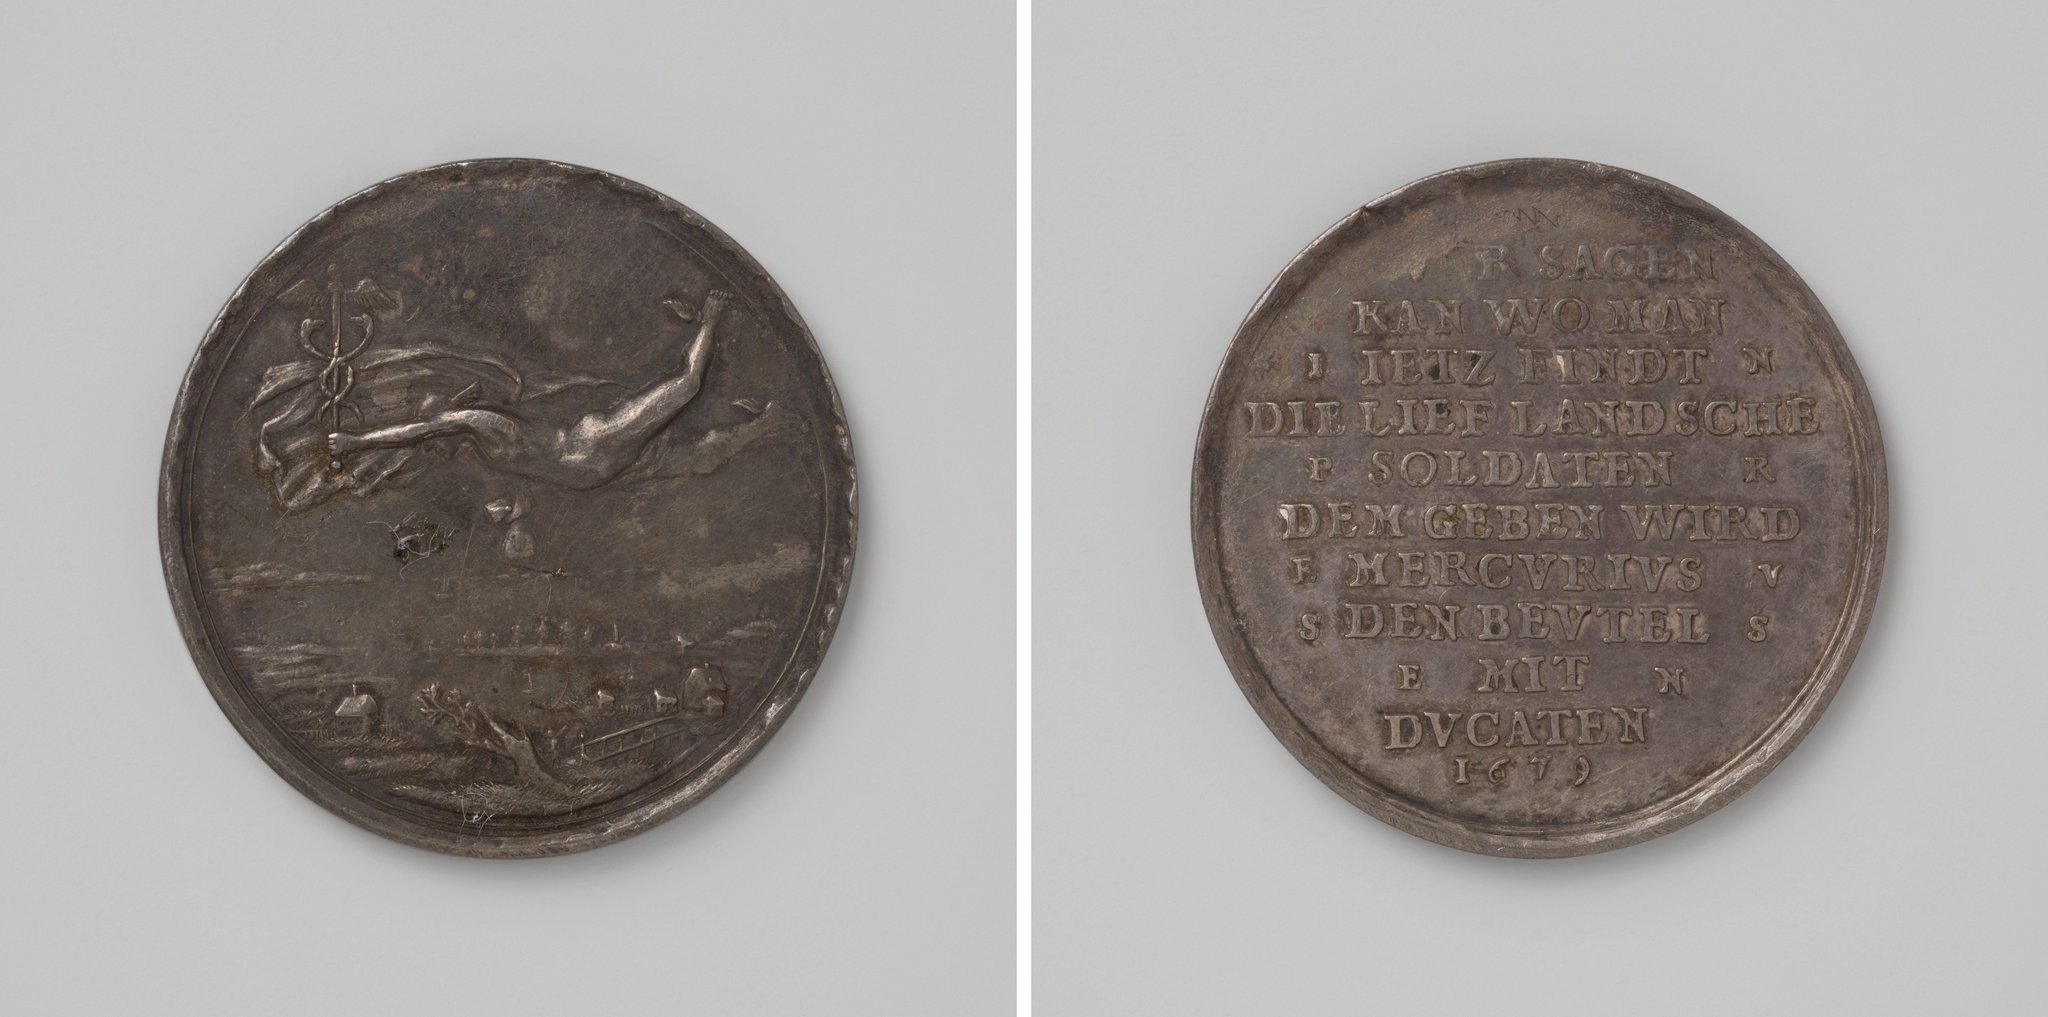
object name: satirical medal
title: Verjaging van de Zweden uit Pruisen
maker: Anonymous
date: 1679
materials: silver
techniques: striking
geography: germany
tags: pruisen, noordse oorlogen, schonense oorlog, verdrijving van de zweden uit pruissen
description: Zilveren penning. Voorzijde: vliegende Mercurius met staf en geldbuidel. Keerzijde: opschrift.